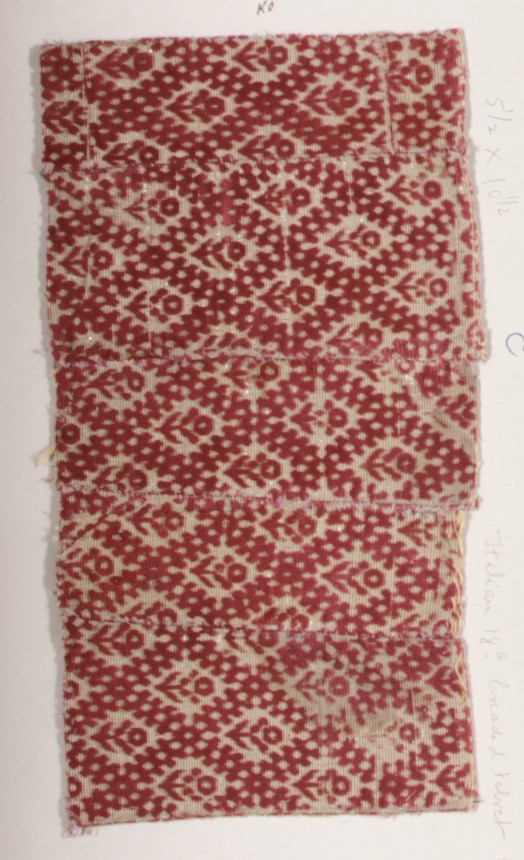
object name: fragment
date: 1701-1800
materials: metal thread, silk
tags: flowers